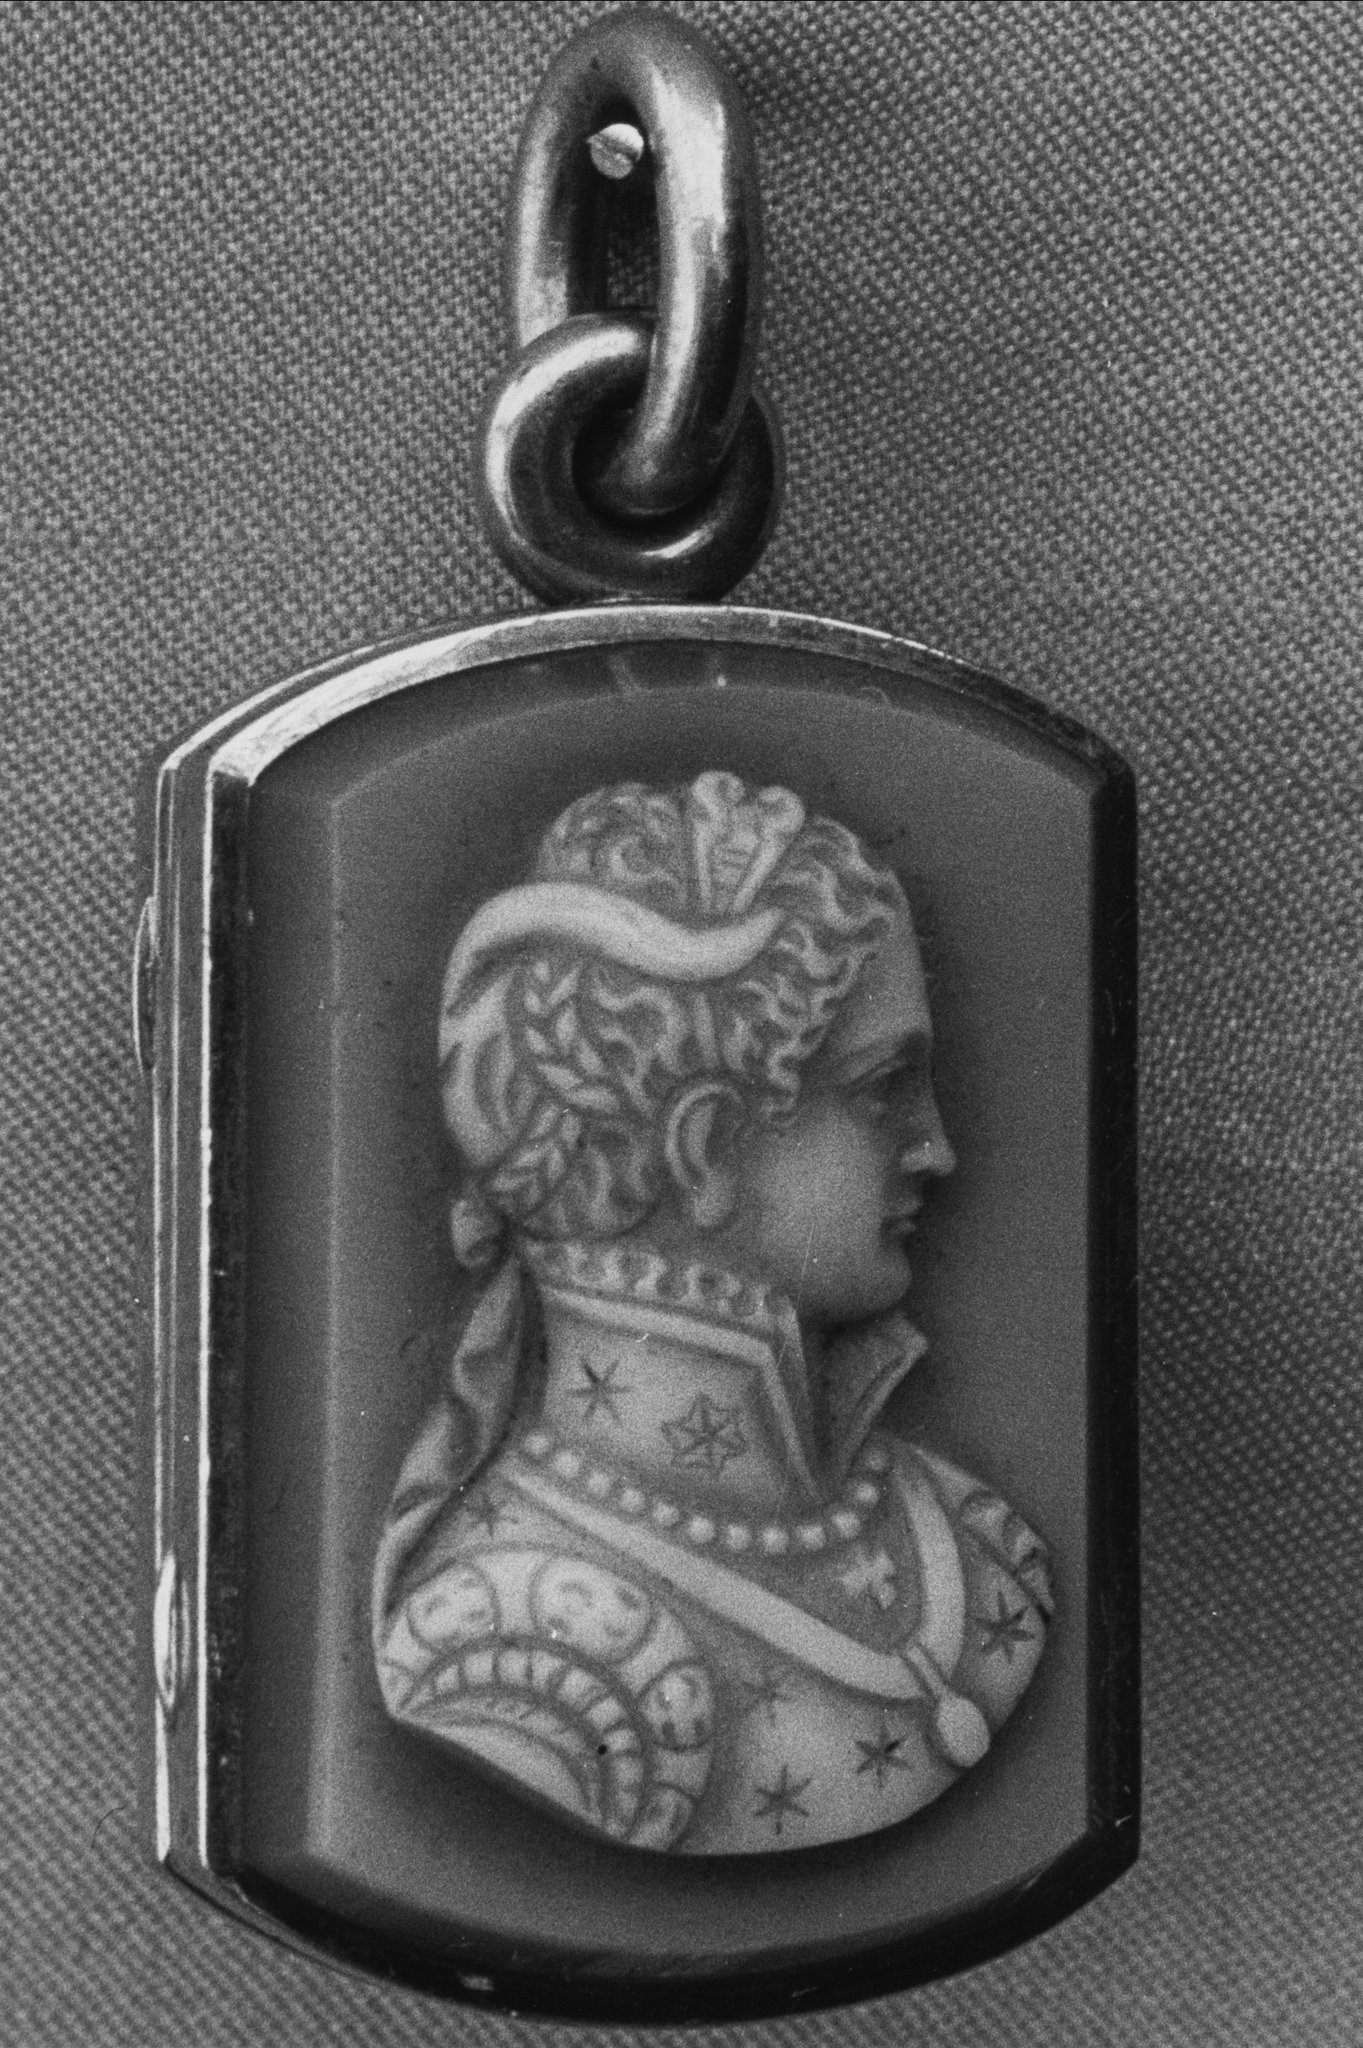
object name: locket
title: Cameo Locket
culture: french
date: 1830-1870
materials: gold, gemstone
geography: france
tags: profiles,women